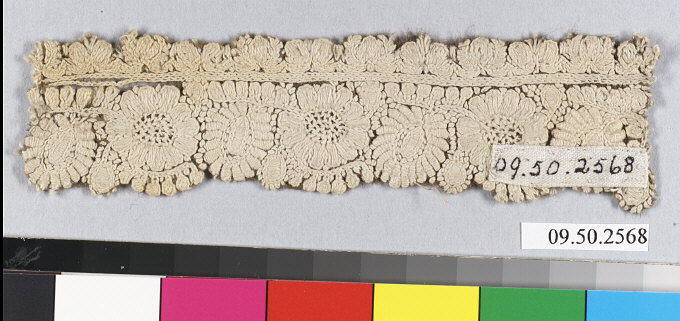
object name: fragment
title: Fragments (6)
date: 1801-1900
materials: silk